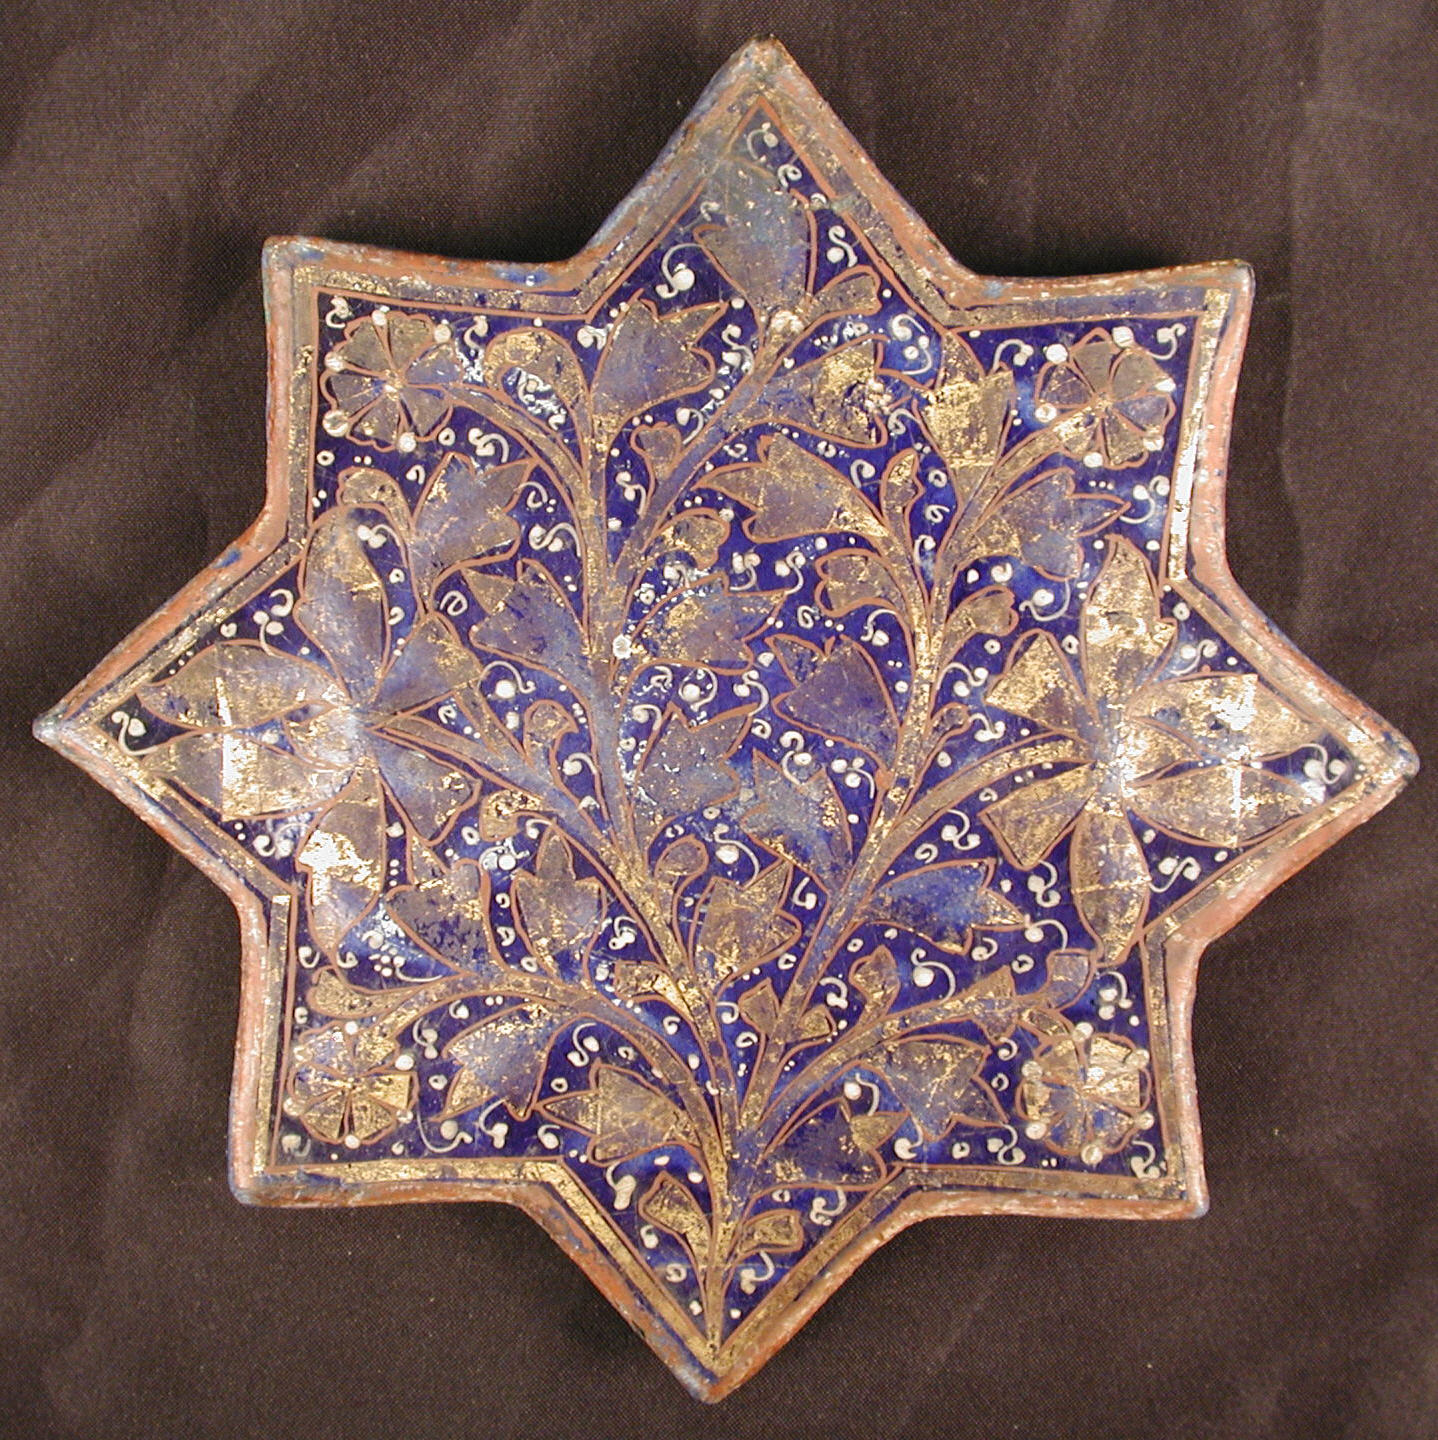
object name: tile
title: Star-Shaped Tile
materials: stonepaste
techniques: gilding, molding, overglaze, painting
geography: iran